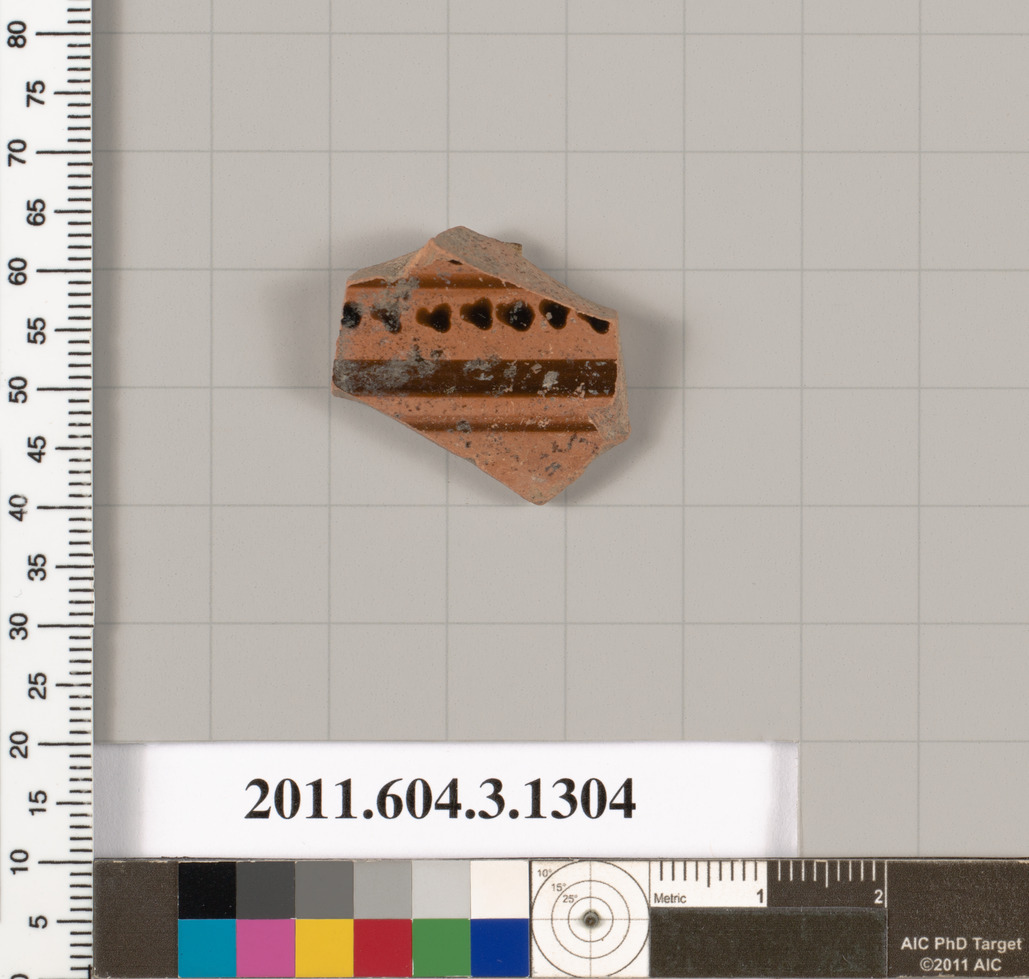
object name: skyphos fragment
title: Terracotta fragment of a skyphos (deep drinking cup)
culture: greek, attic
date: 534-468 BCE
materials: terracotta